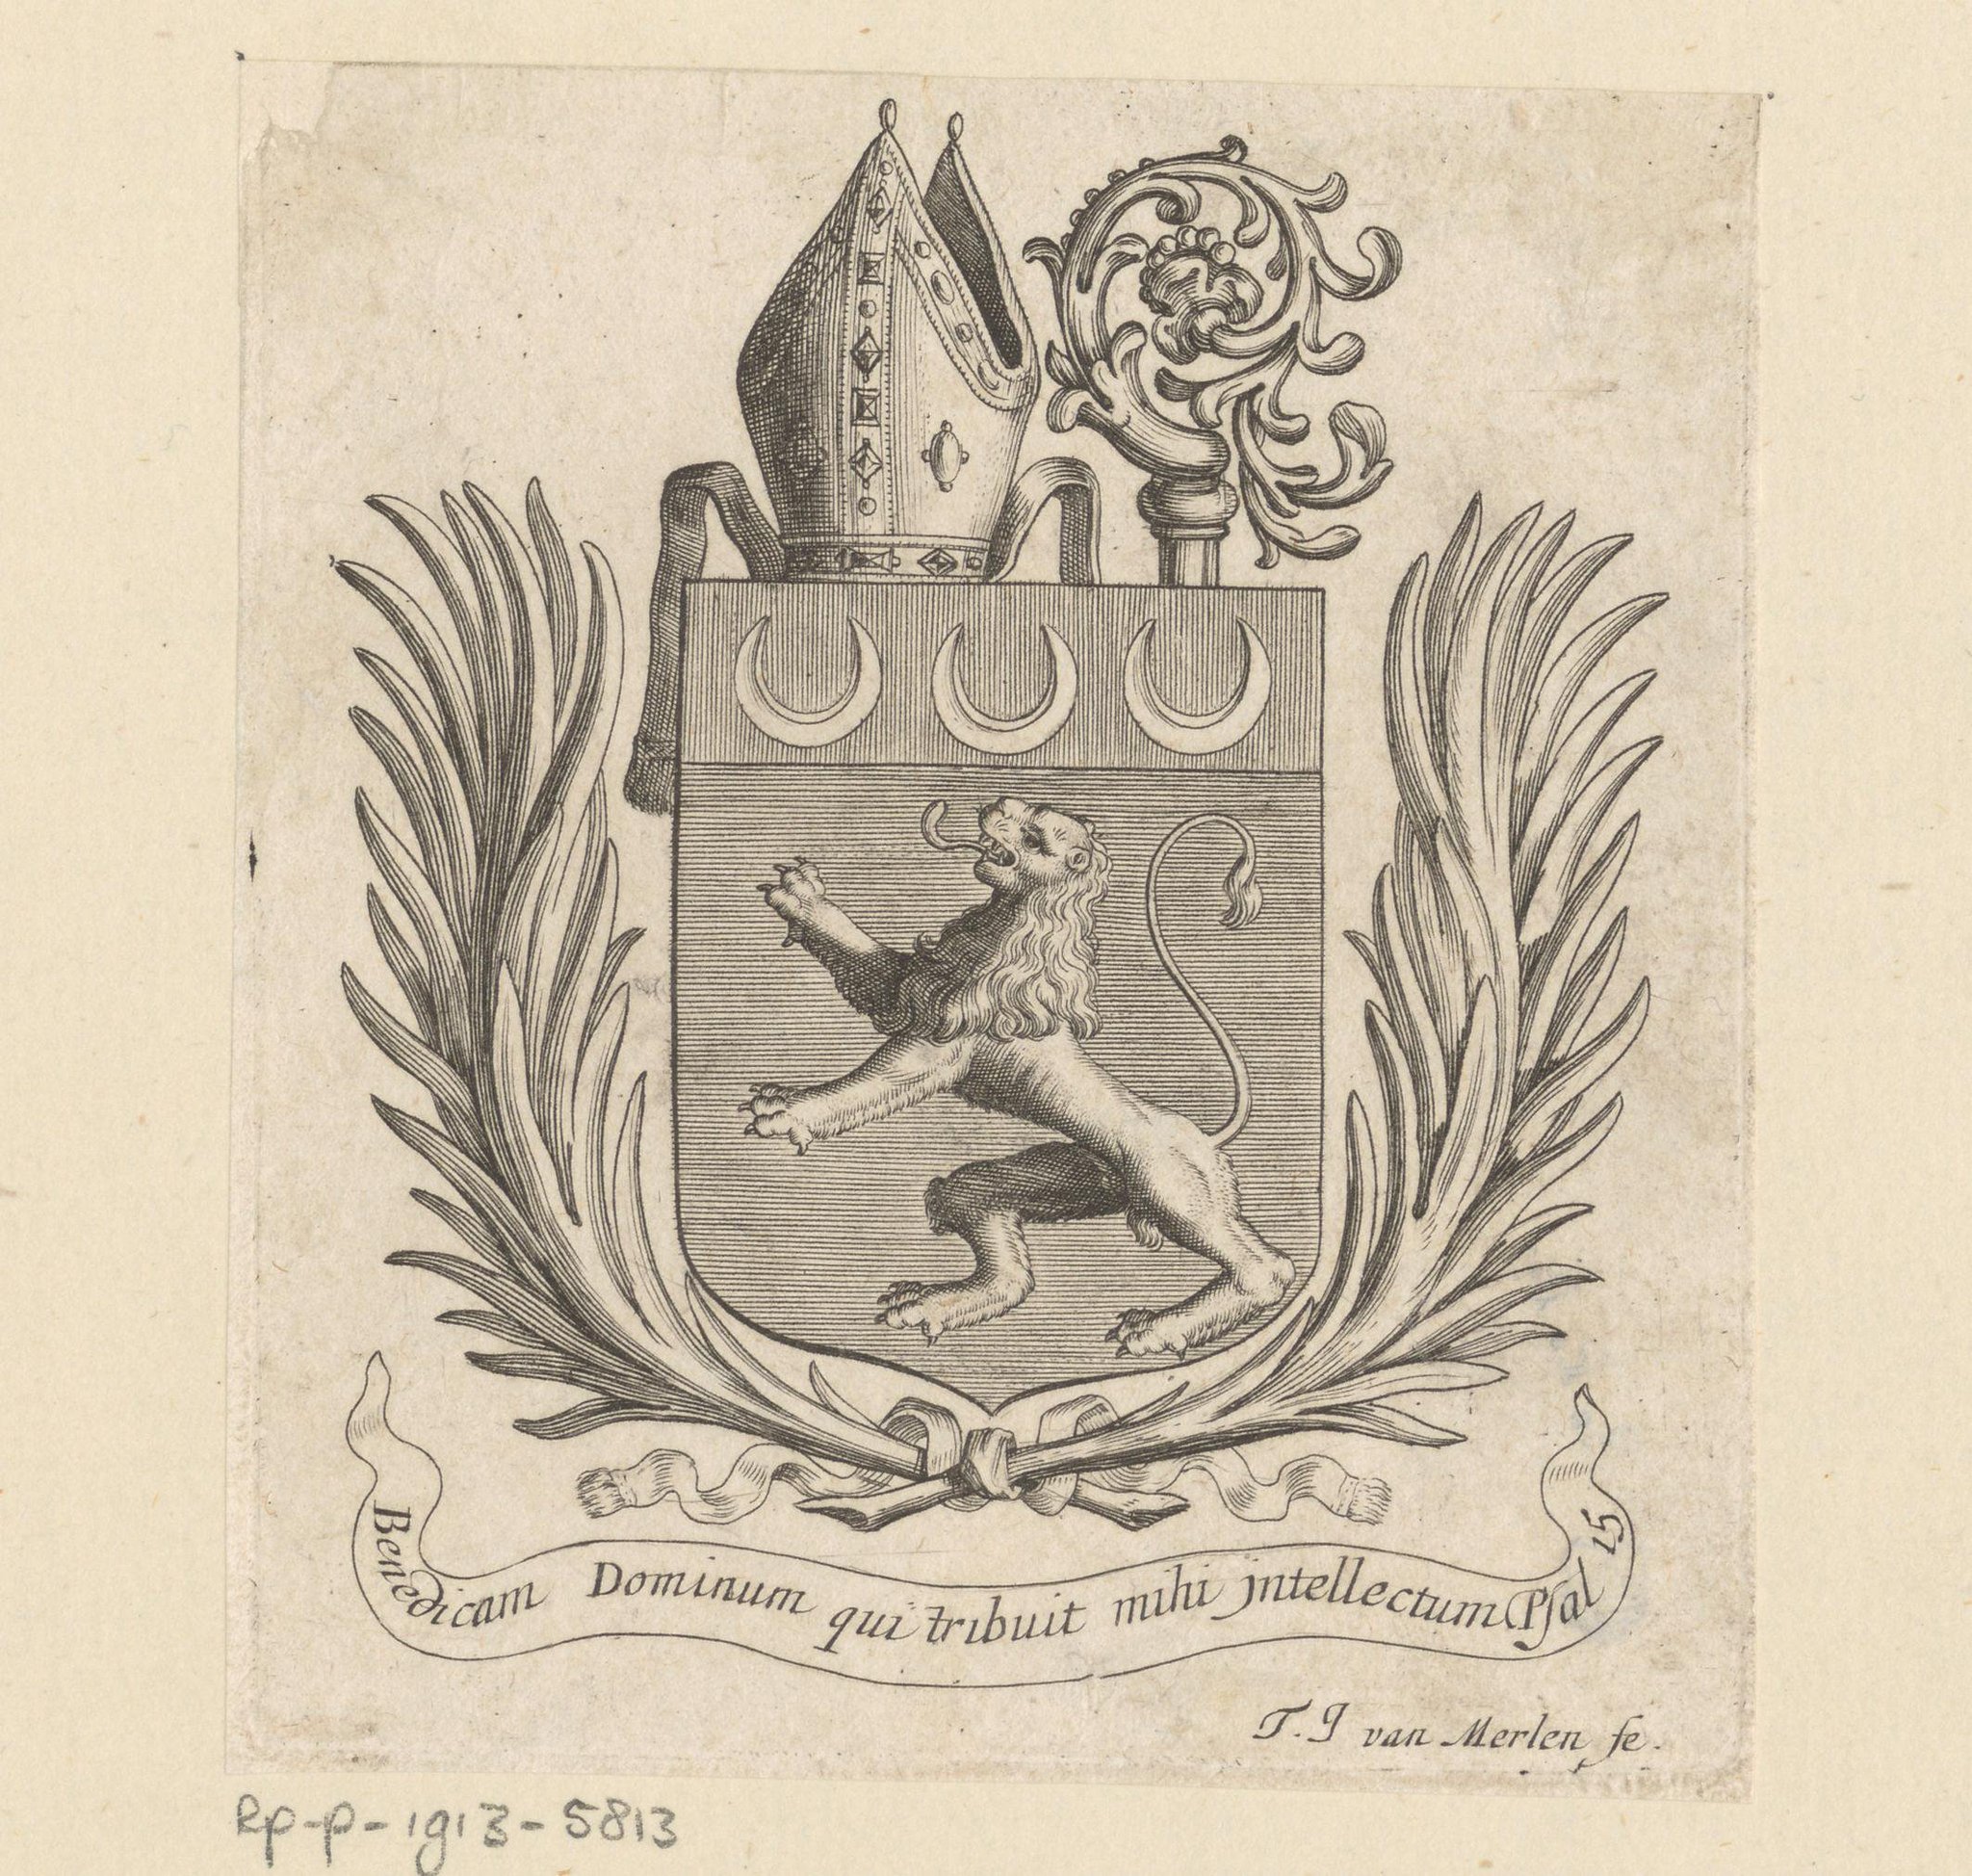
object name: bookplate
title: Benedicam Dominum qui tribuit mihi intellectum Psal 15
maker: theodor van merlen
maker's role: draughtsman, print maker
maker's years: 1604-1659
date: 1650-1749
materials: paper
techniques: engraving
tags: armorial bearing, heraldry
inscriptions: collector's mark: Lugt 2233, collector's mark: Lugt 2760